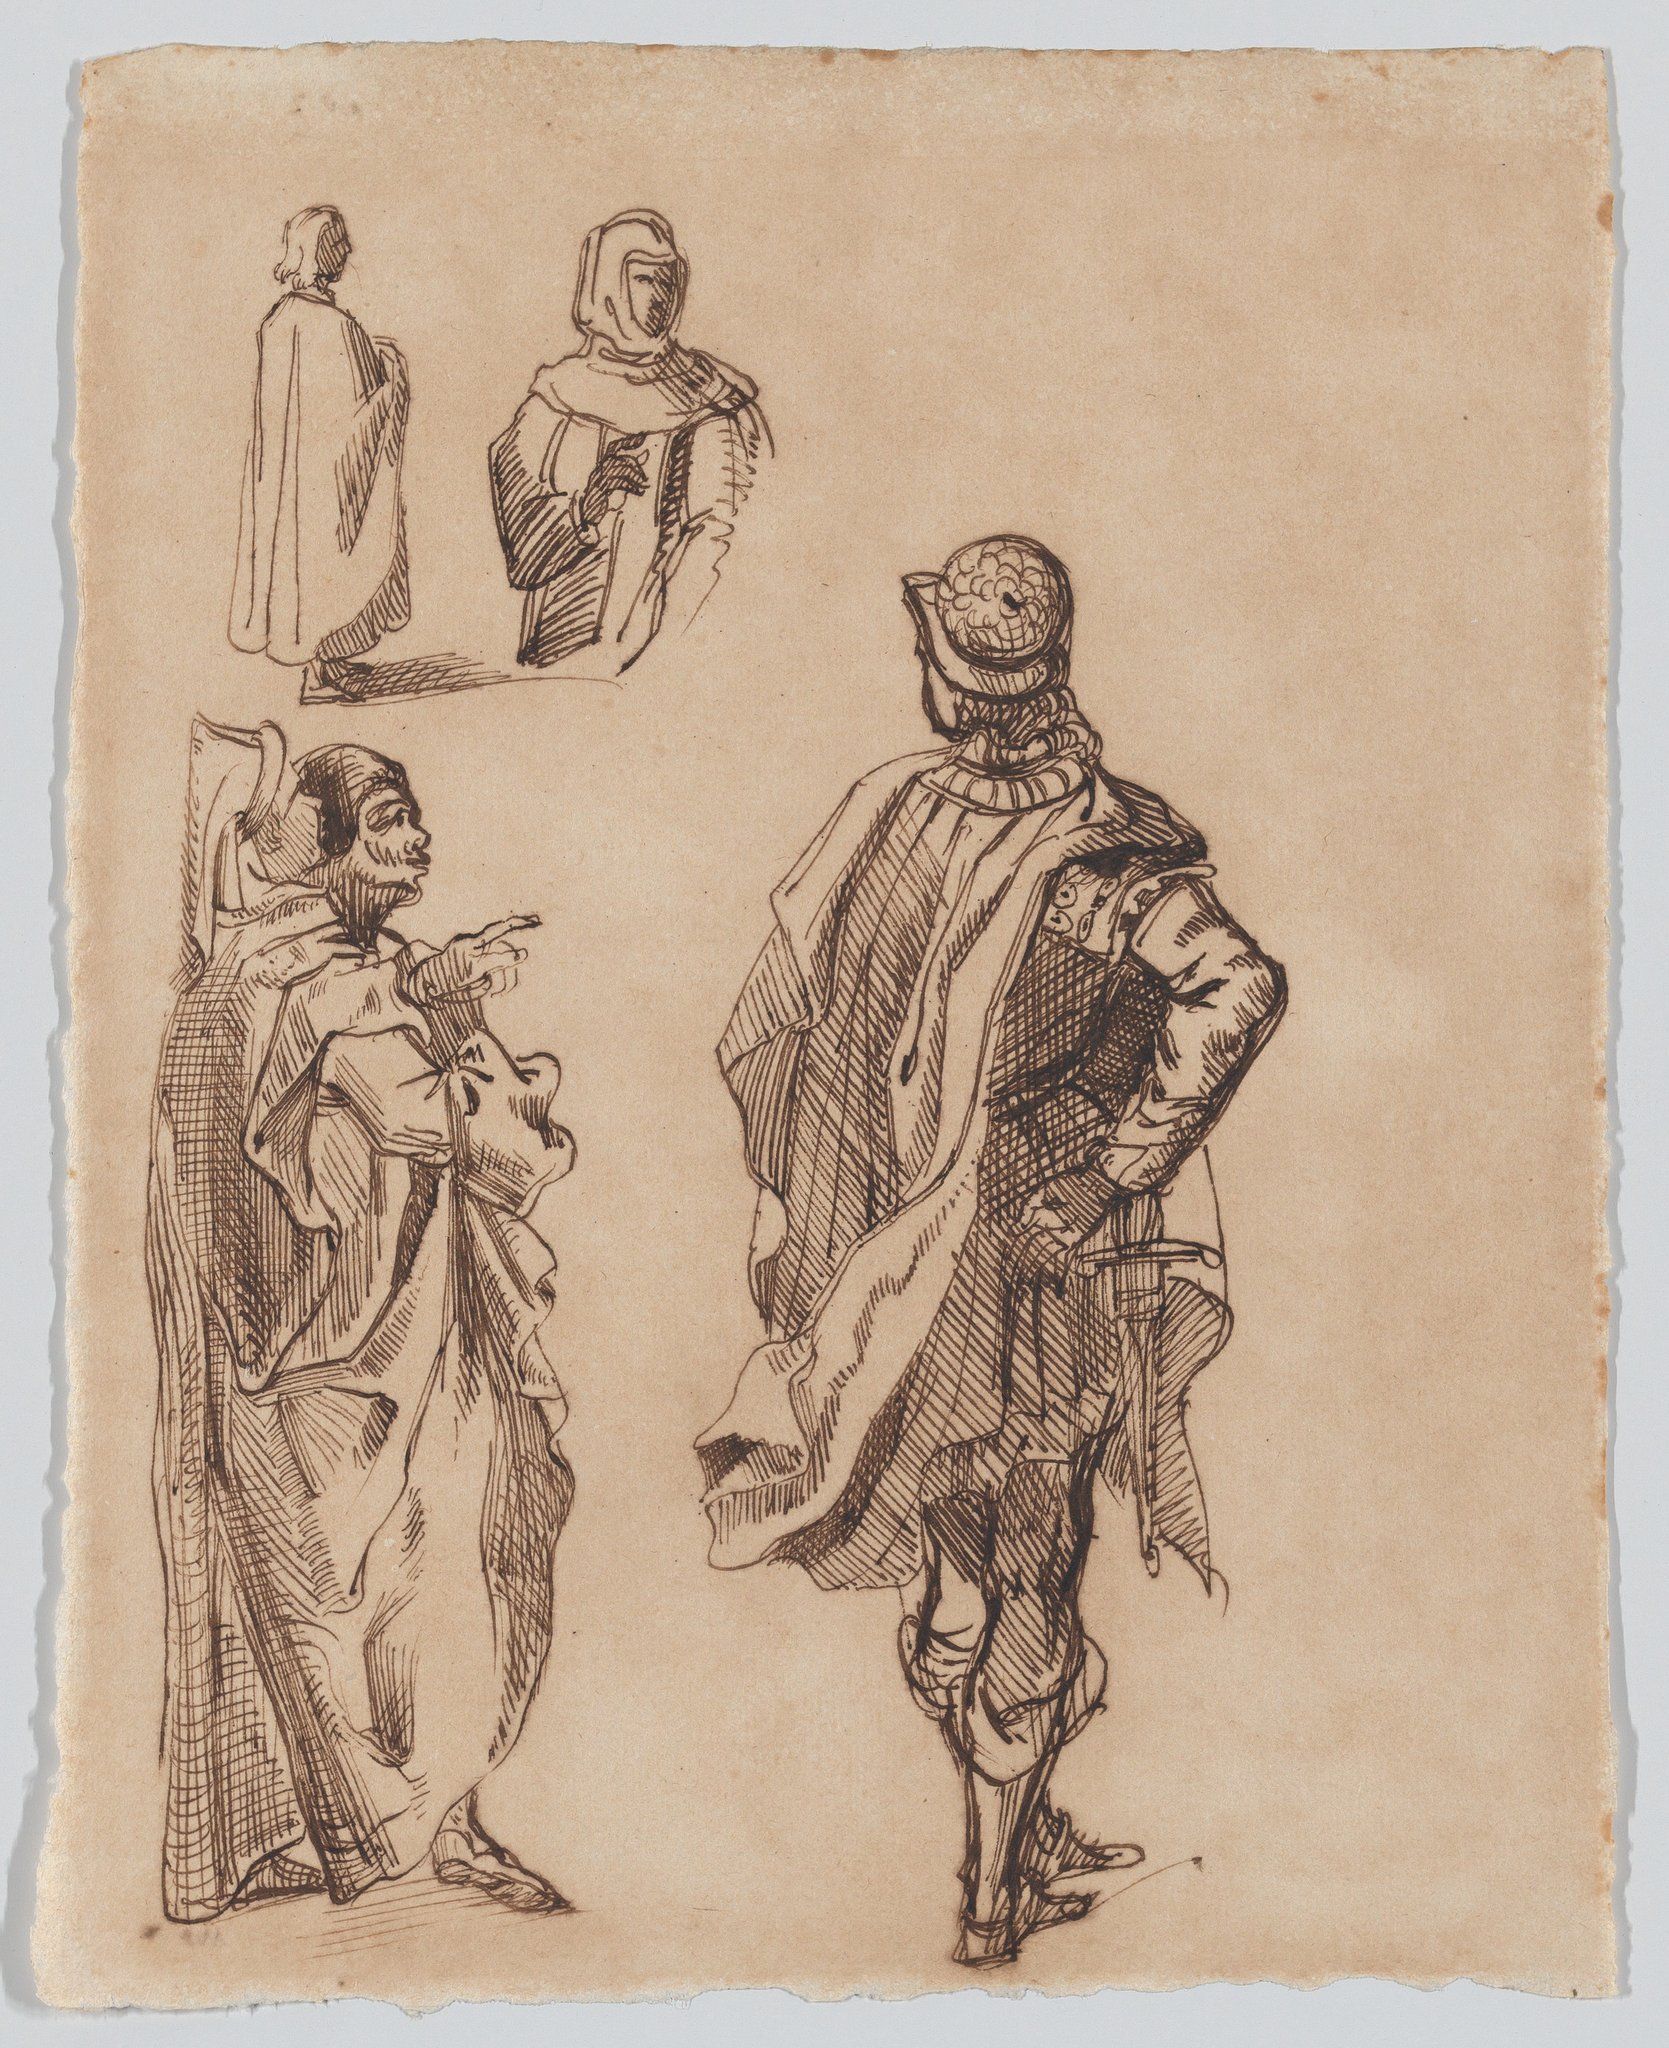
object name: drawing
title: Five Figures in Medieval Dress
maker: eugène delacroix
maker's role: artist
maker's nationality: french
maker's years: 1798-1863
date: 1827-1829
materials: ink, iron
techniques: pen